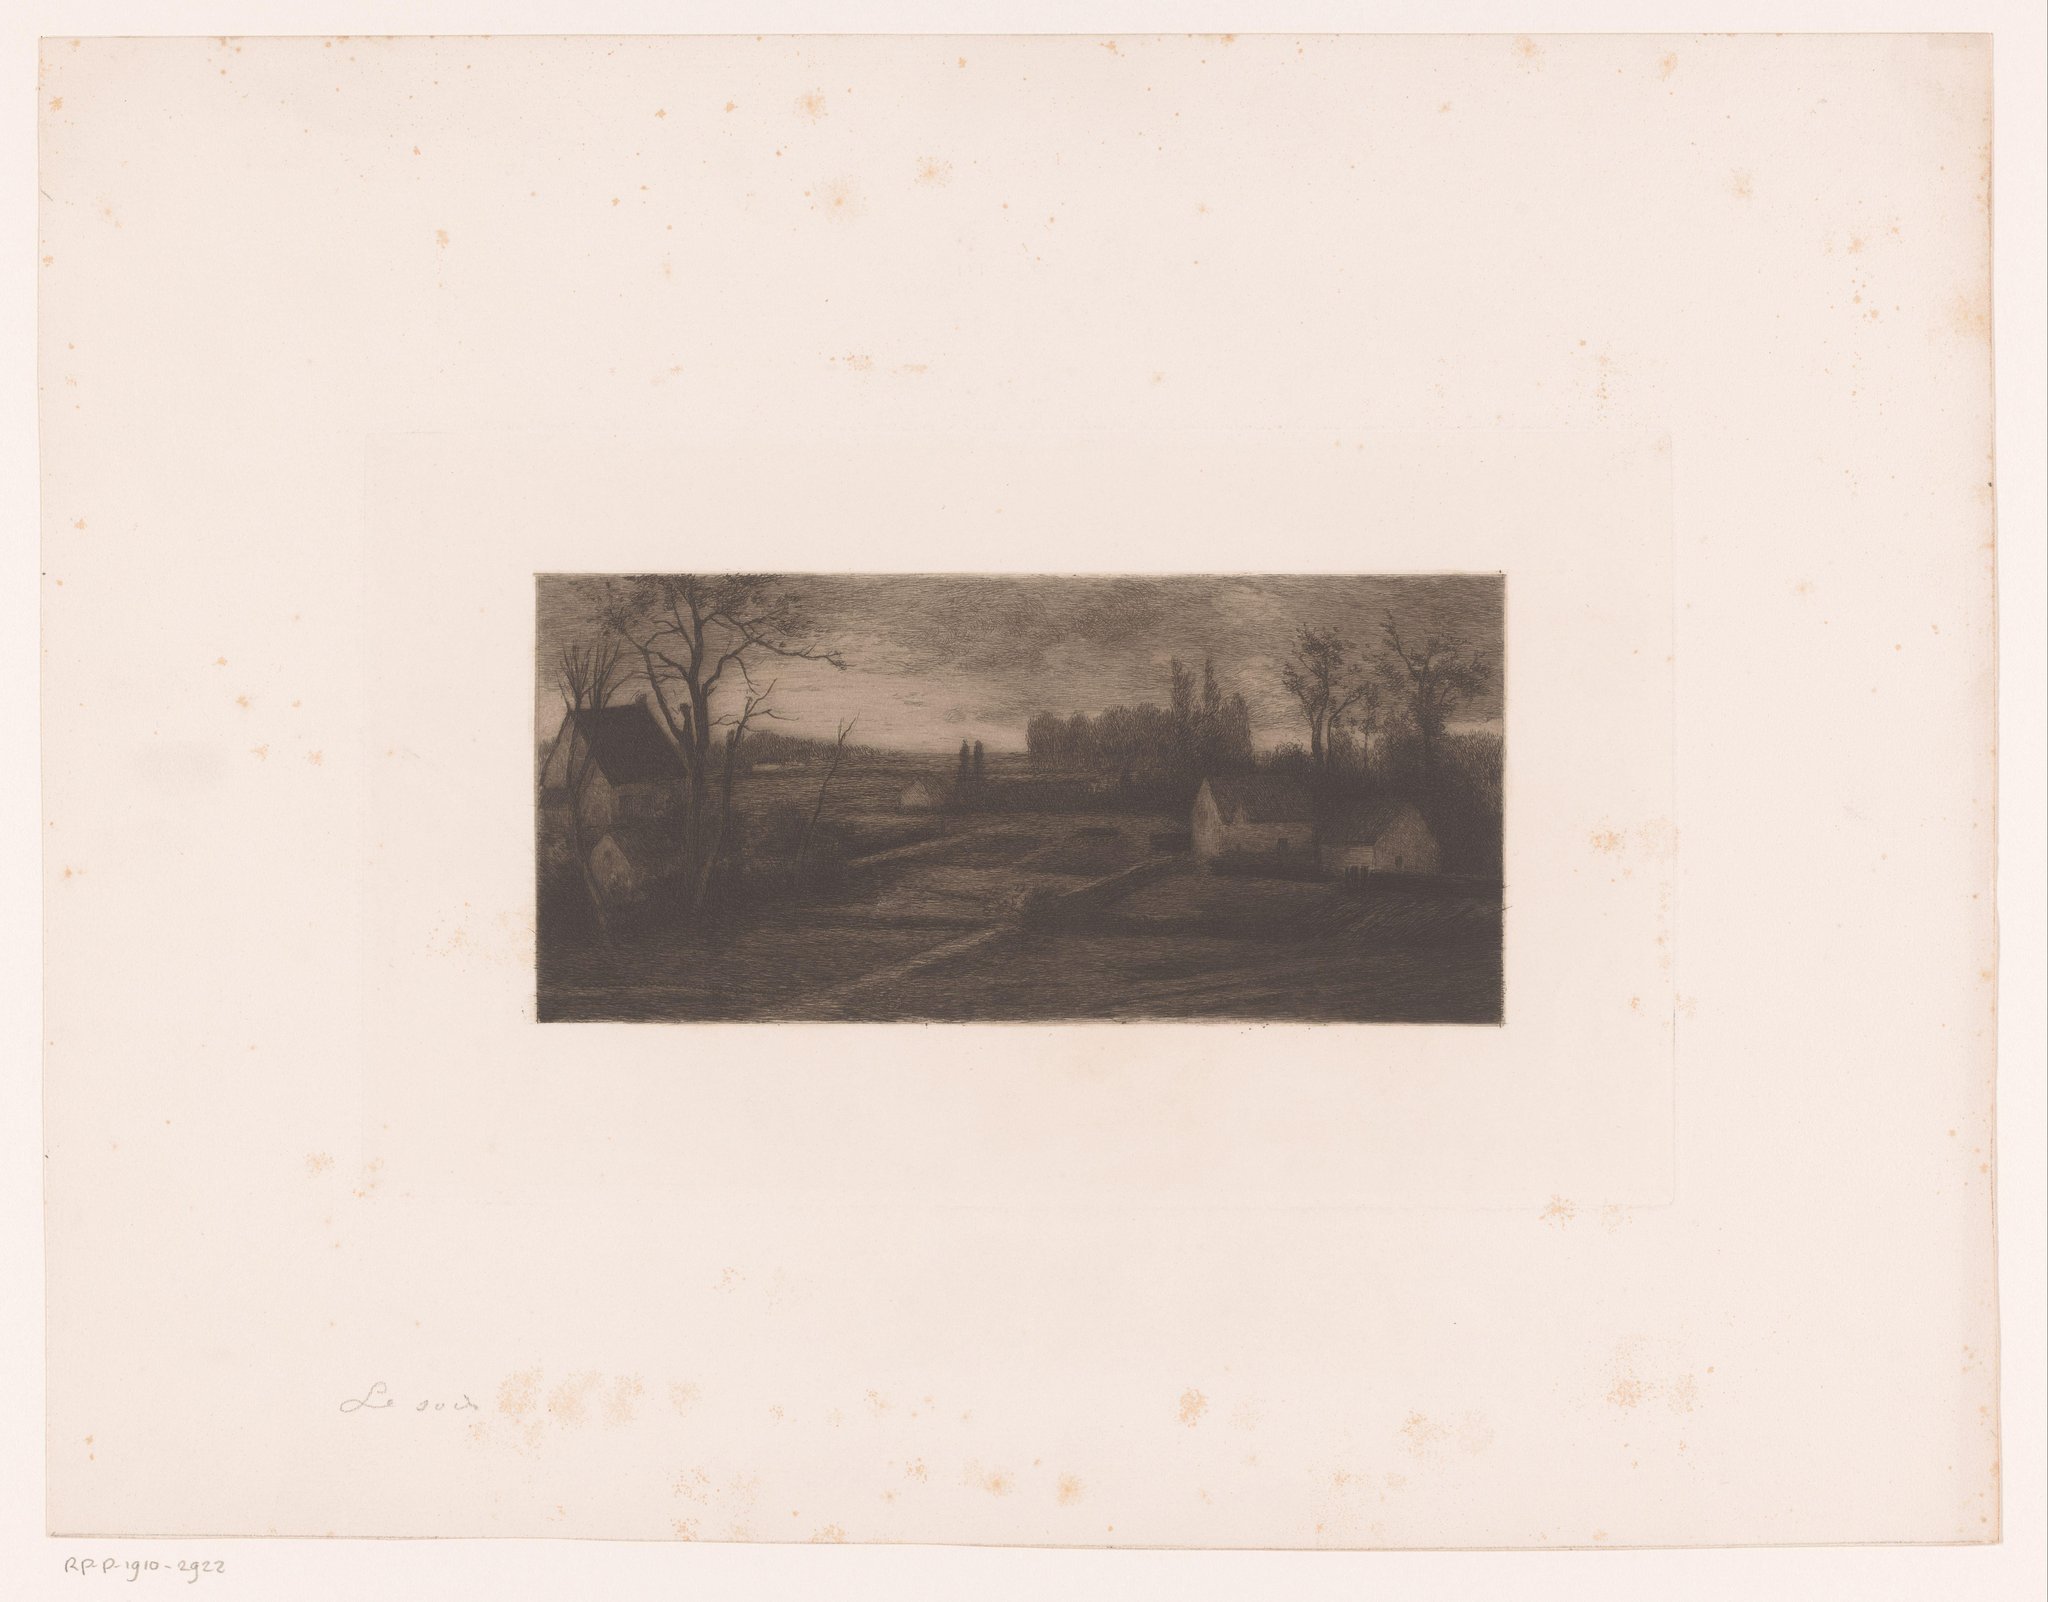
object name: print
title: Landschap met boerderijen bij avond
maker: alfred elsen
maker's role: painter, print maker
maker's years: 1850-1914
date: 1860-1910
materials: paper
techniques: etching, intaglio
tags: city-view, and landscape with man-made constructions, landscapes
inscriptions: collector's mark: Lugt 2228, inscription: ‘Le soir’